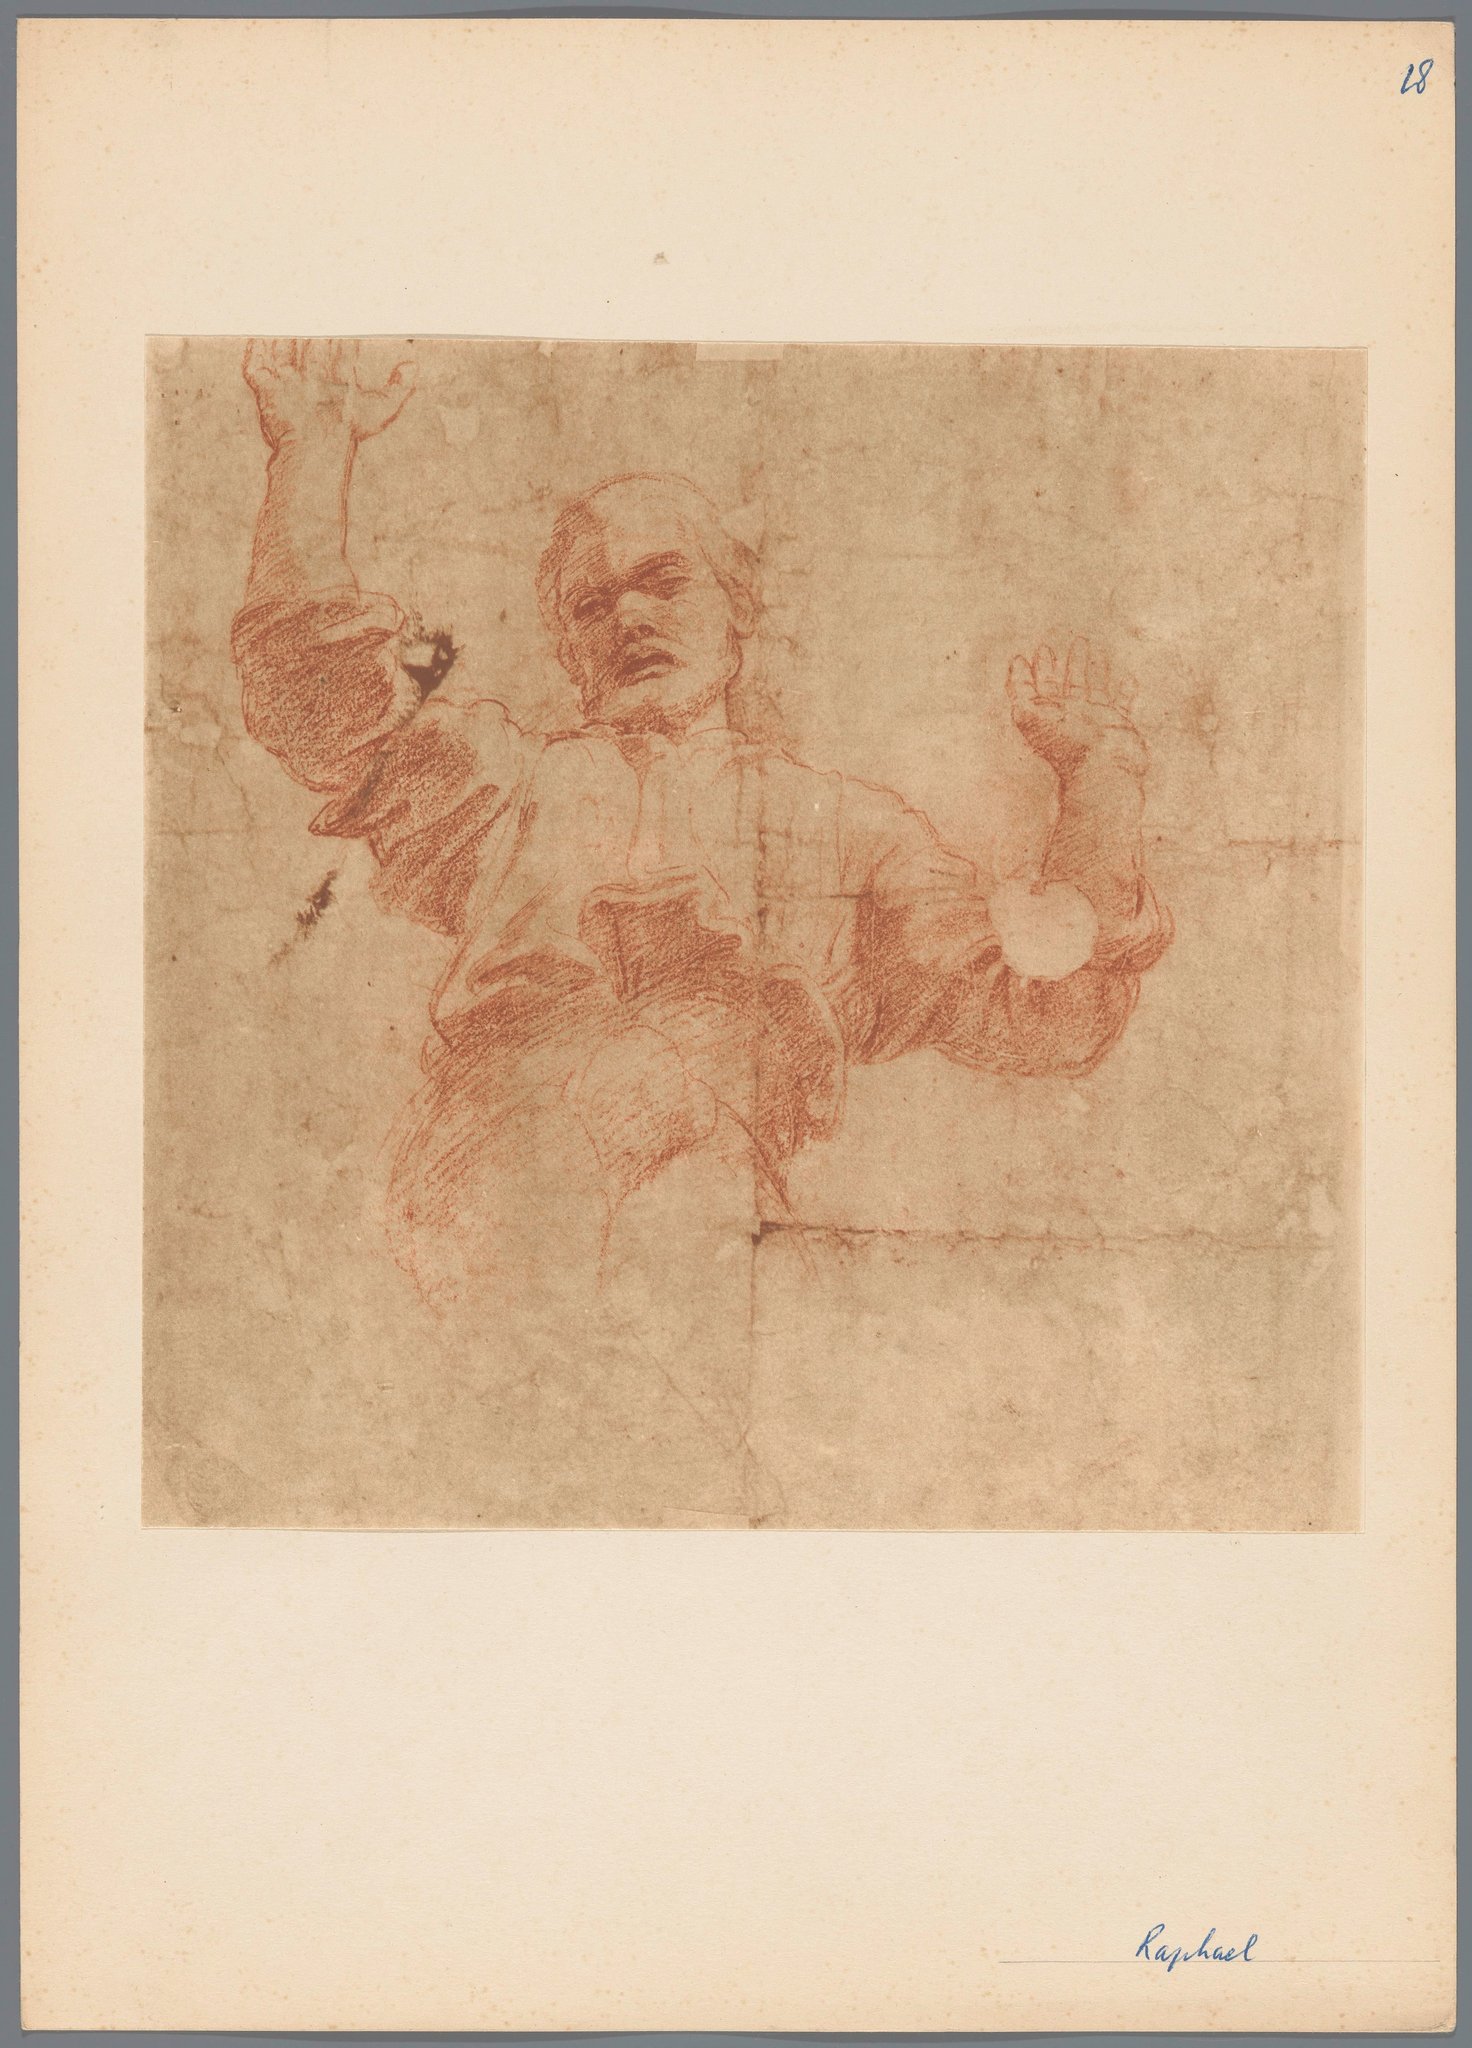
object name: photomechanical print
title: Reproductie van Studie van God de Vader van Rafaël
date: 1850-1950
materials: cardboard, paper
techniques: photograph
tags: god the father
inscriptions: number: ‘18’, inscription: ‘Raphael/ Studie v. mozaiek in S. Maria del Popolo, Rome/ Ashmolean Mus Oxford/ zie andere studie zelfde onderw.’, collector's mark: ‘Instituut v. kunstn./ afd. opl tot teekenl.’, inscription: ‘Raphael’